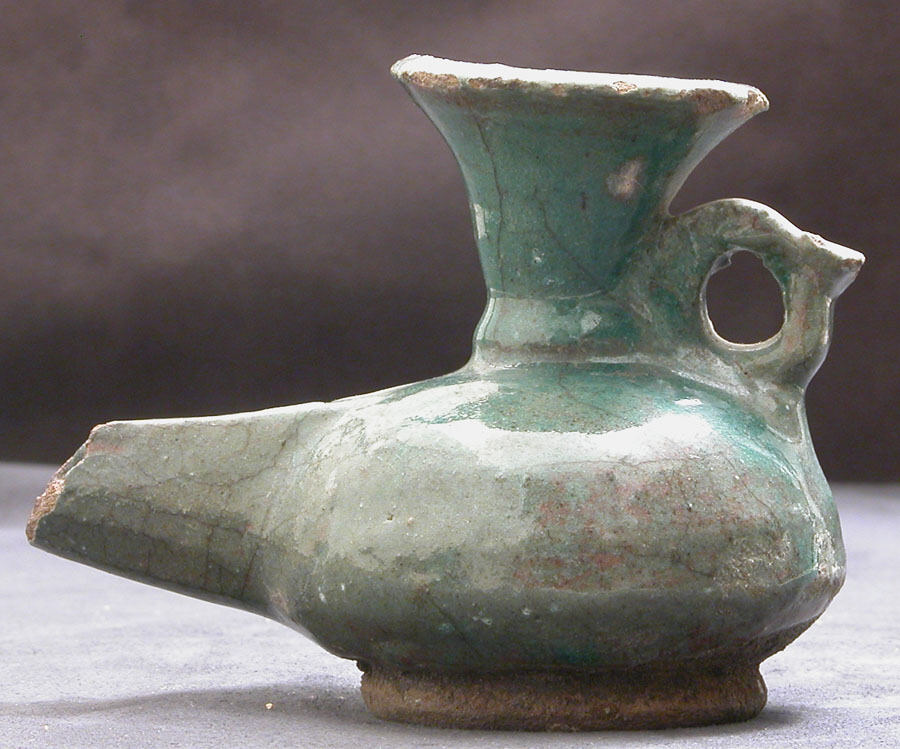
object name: lamp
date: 1201-1400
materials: earthenware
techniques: glazing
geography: egypt